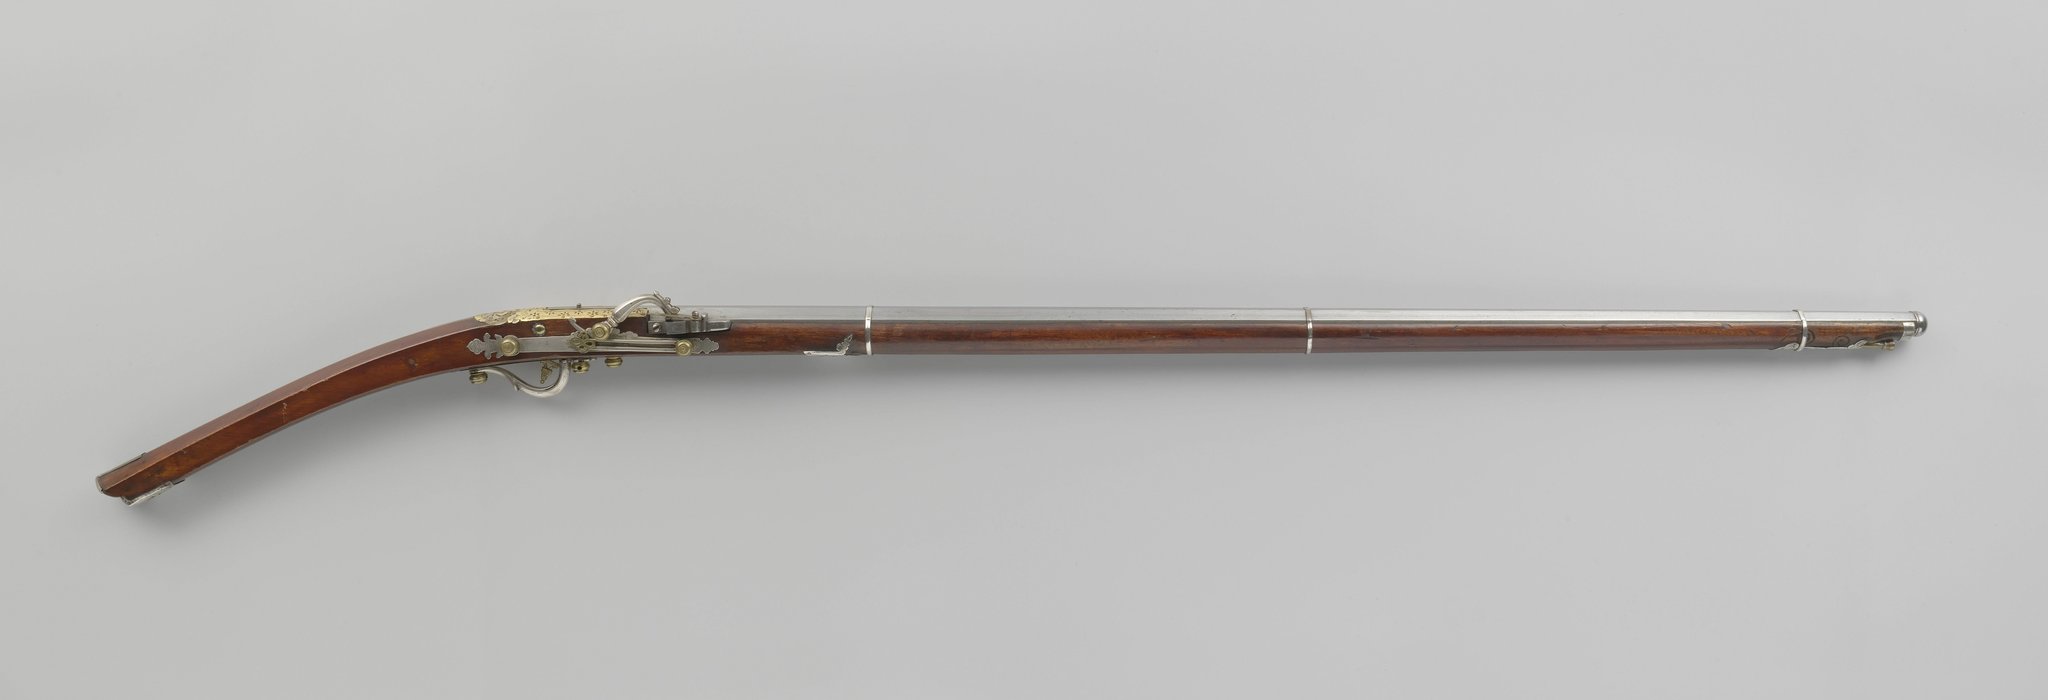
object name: matchlock rifle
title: Lontslotgeweer behorend bij wapenrek van Cornelis Tromp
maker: Anonymous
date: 1650-1679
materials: bone, copper, iron, lacquer, mother of pearl, silver, wood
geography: north vietnam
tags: rotterdam, amsterdam, cornelis tromp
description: Arms collection of Cornelis Tromp. These weapons were kept at the Amsterdam home of Cornelis Tromp. The collection included contemporary weapons of exceptional quality and several exotic weapons acquired for their curiosity value. Tromp probably received many of these weapons as gifts during his patrols of the Mediterranean Sea and in the Baltic.